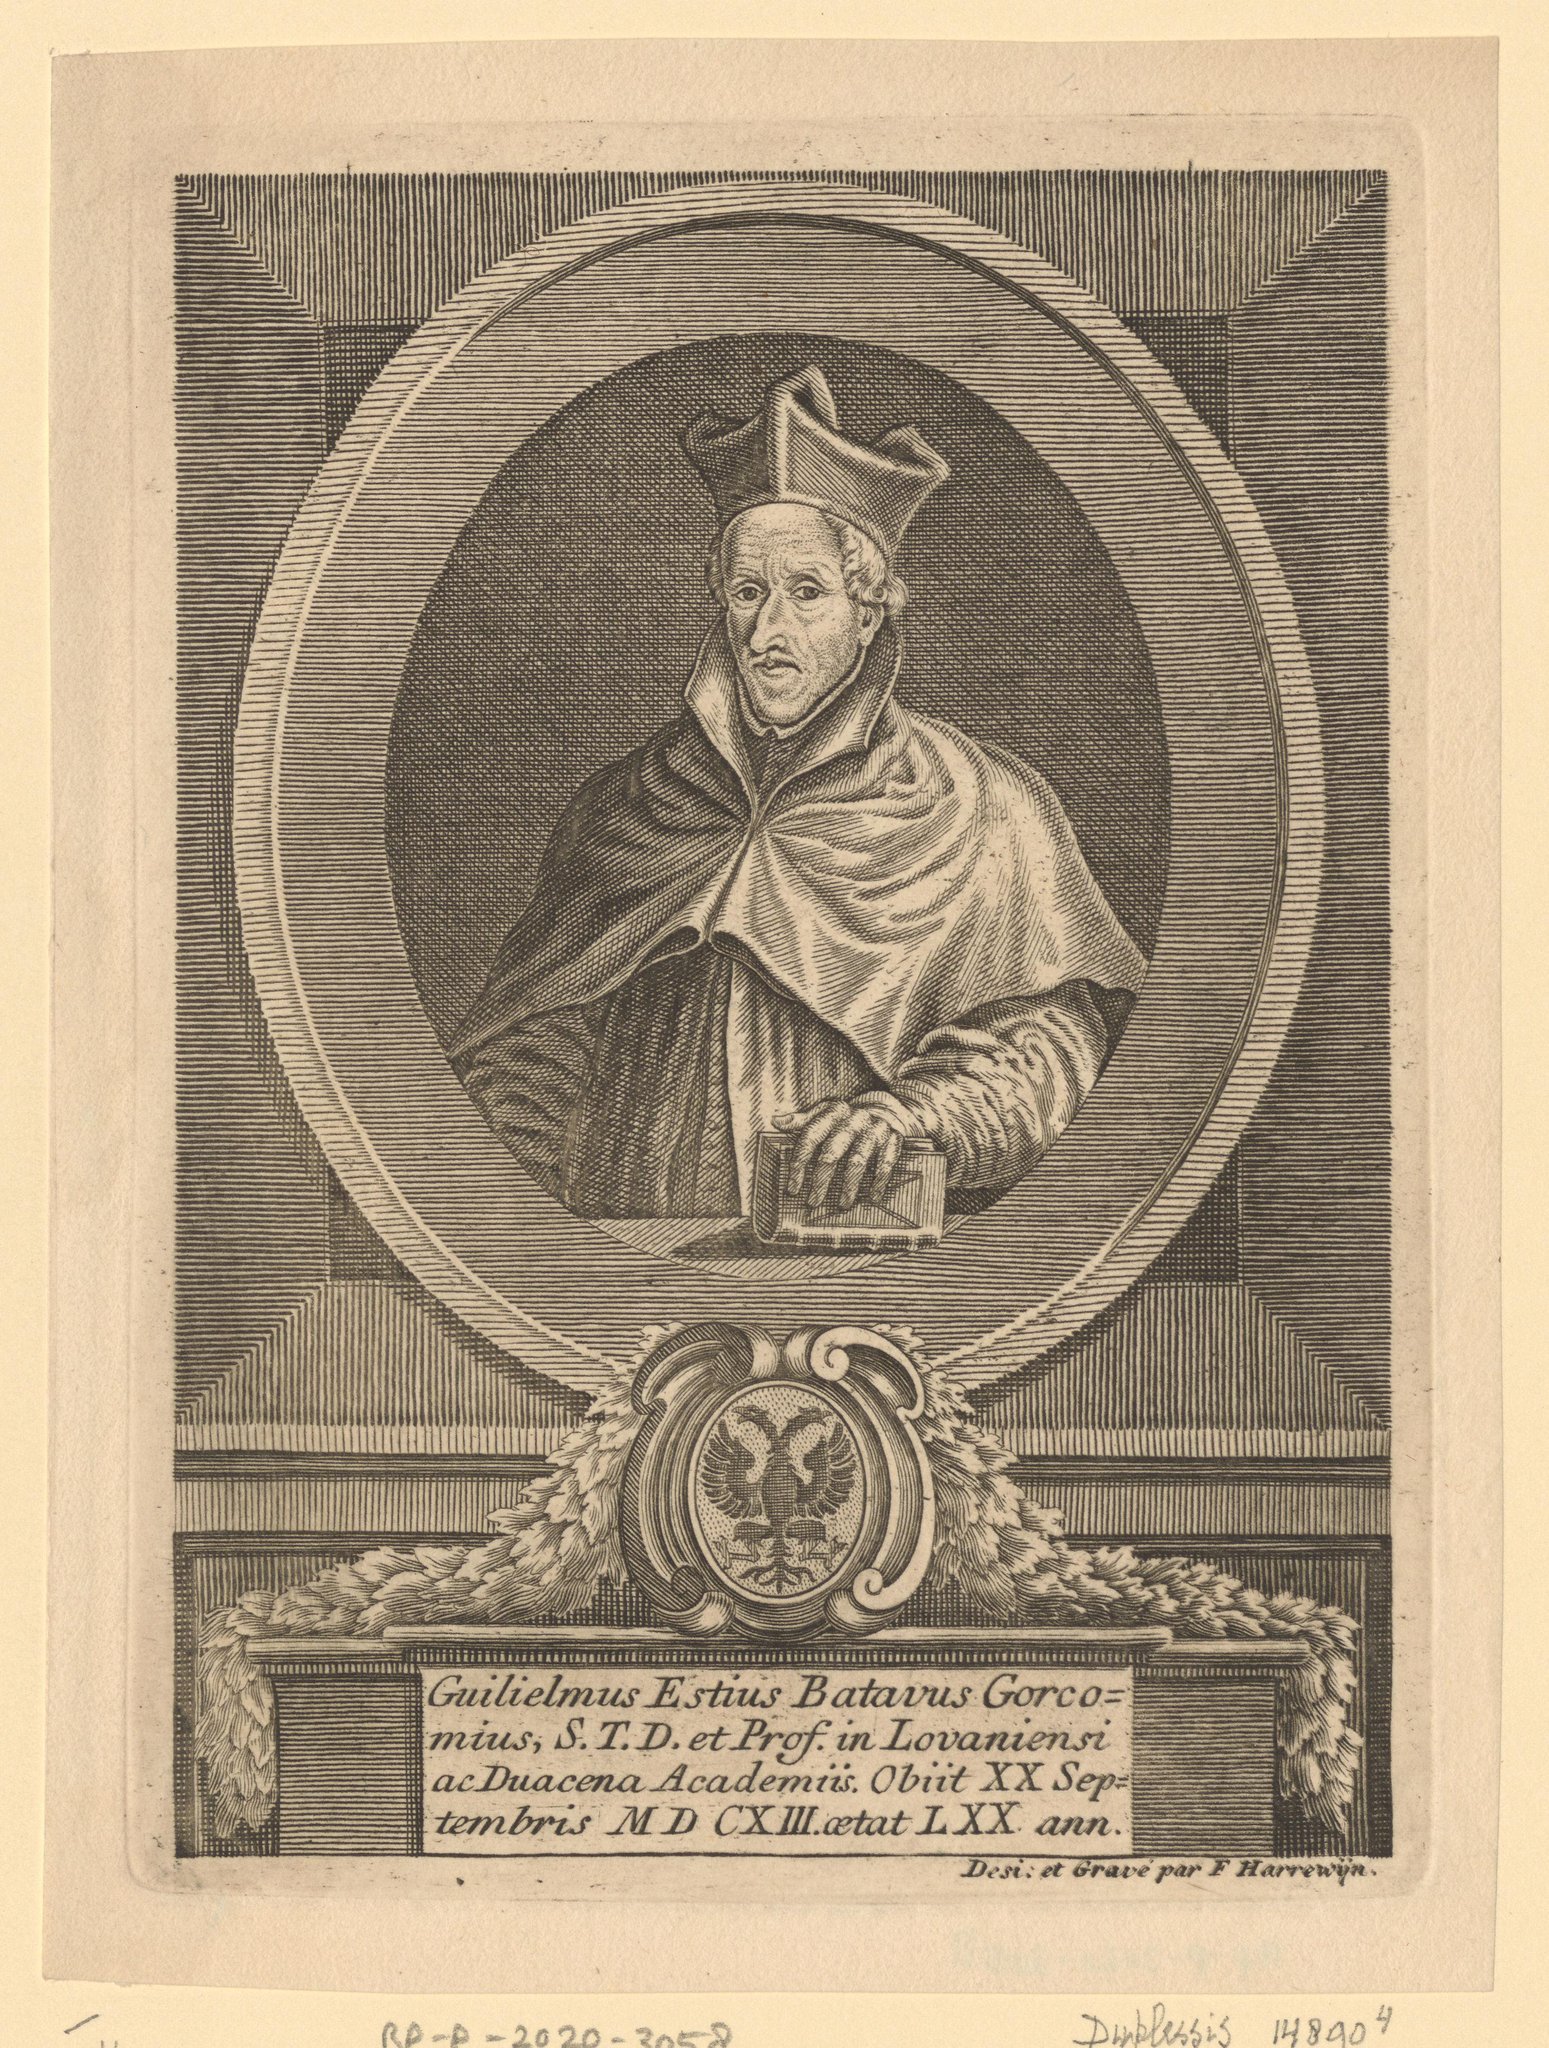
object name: print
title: Portret van Willem Hessels van Est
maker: françois harrewijn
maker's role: print maker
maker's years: 1700-1764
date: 1739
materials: paper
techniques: engraving, etching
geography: brussels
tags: theologian, historical persons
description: Prent waarschijnlijk uit: Foppens, J.F. Bibliotheca Belgica (...). Brussel: Petrus Foppens, 1739.